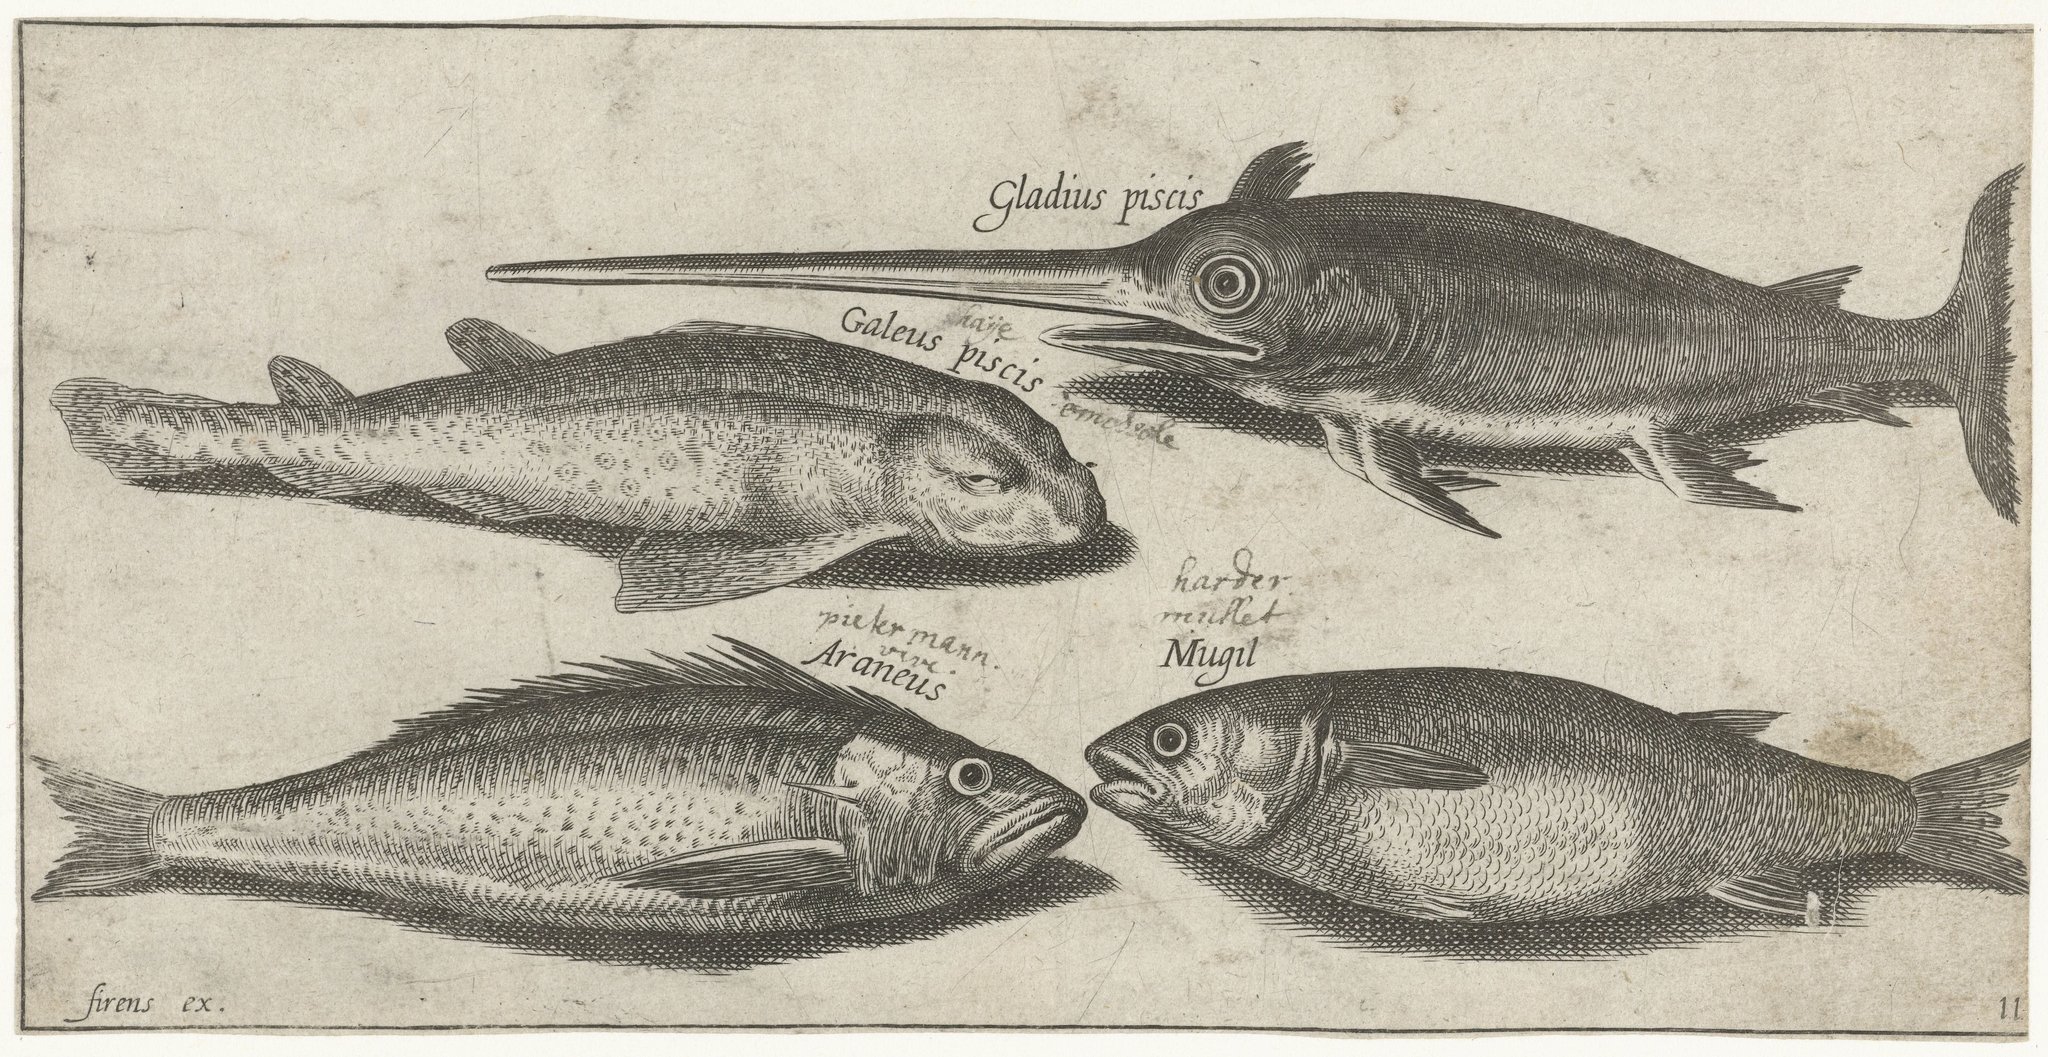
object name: print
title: Piscivm vivae icones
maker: pierre firens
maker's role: print maker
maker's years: 1580-1638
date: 1600-1638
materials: paper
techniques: engraving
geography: paris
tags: fishes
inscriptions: collector's mark: Lugt 2228